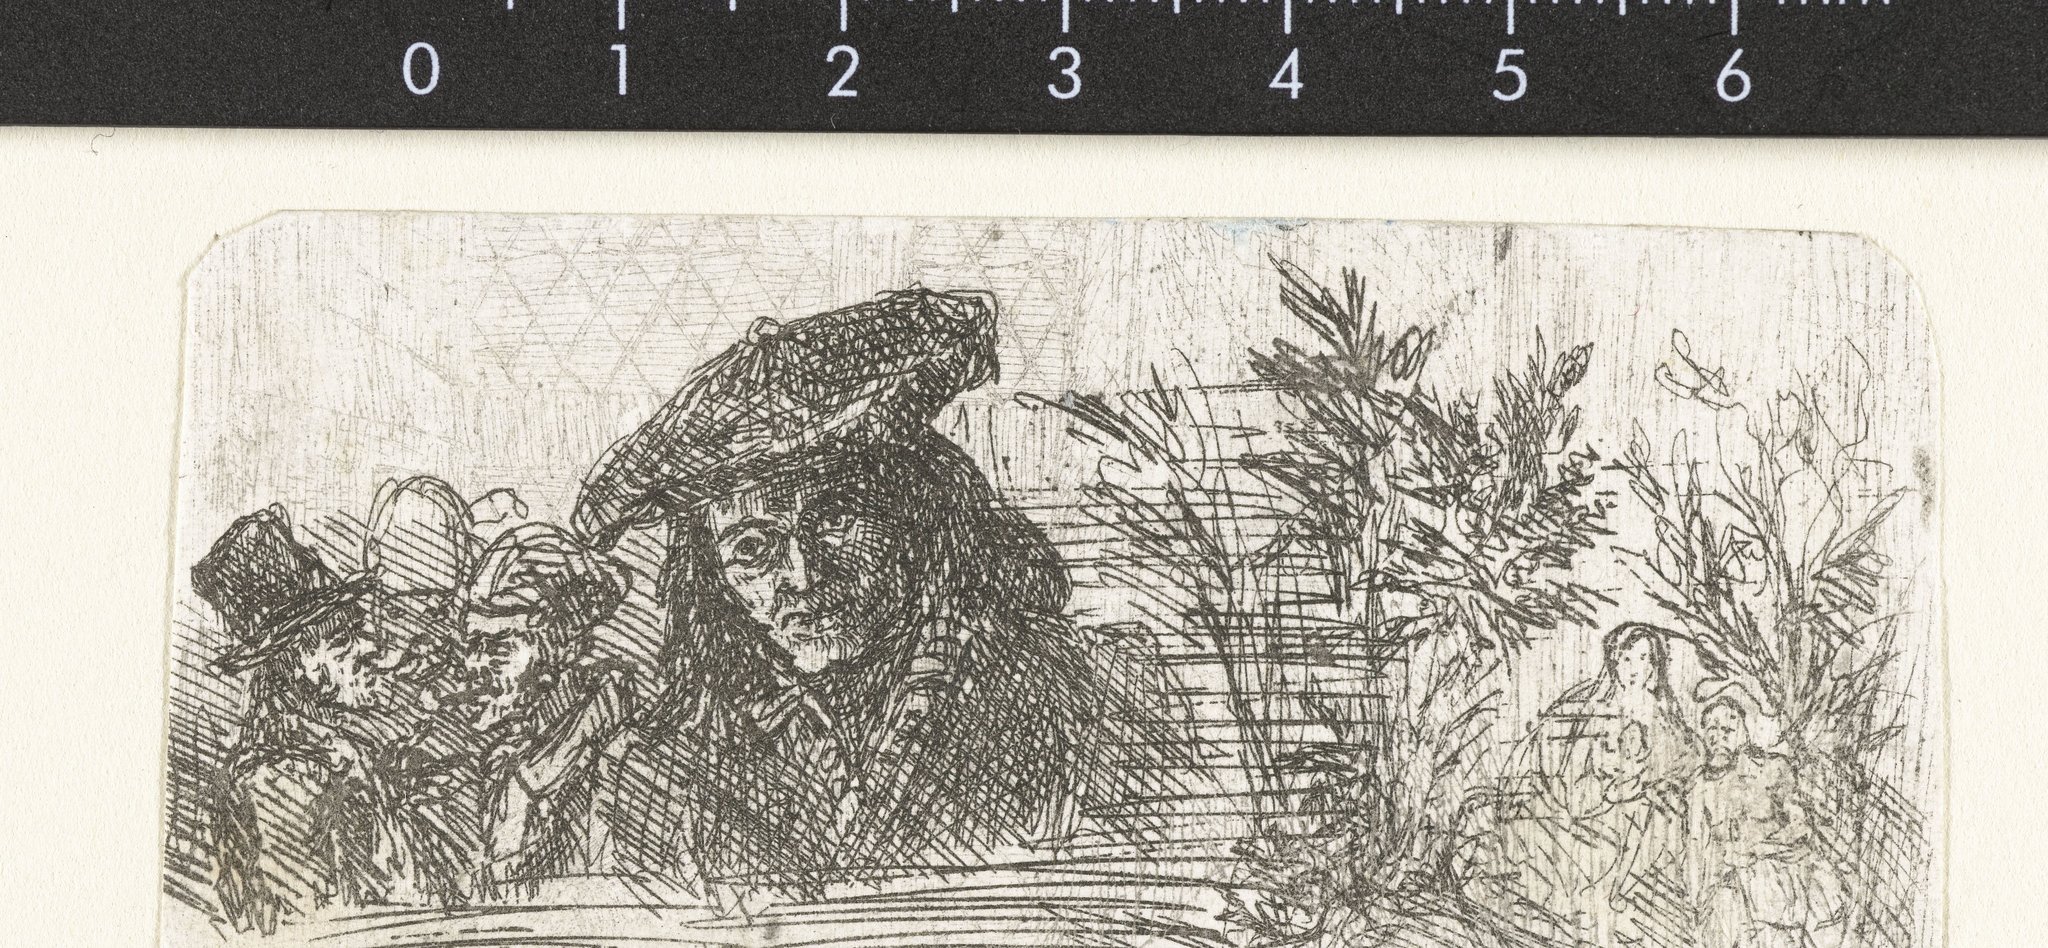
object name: print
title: Blad met studies van hoofden en rust op de vlucht naar Egypte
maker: rodolphe bresdin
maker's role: draughtsman, print maker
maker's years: 1822-1885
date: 1844-1849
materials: paper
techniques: etching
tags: head (human), rest on the flight into egypt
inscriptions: collector's mark, collector's mark: Lugt 2760, collector's mark: Lugt 2069a, collector's mark: Lugt 2228, inscription: ‘Acheté de Paul Bresdin/ 6/5 29 P. et R. Nice’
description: Links een schets van een groepje van drie mannenhoofden met hoofddeksels en daarnaast een grotere studie van aan mannenhoofd met een baret. De rechterhelft van de prent is gevuld met een studie voor een rust op de vlucht naar Egypte. In schetsmatige lijnen zijn de kleine figuren van Maria met kind en Jozef weergegeven tussen bomen.